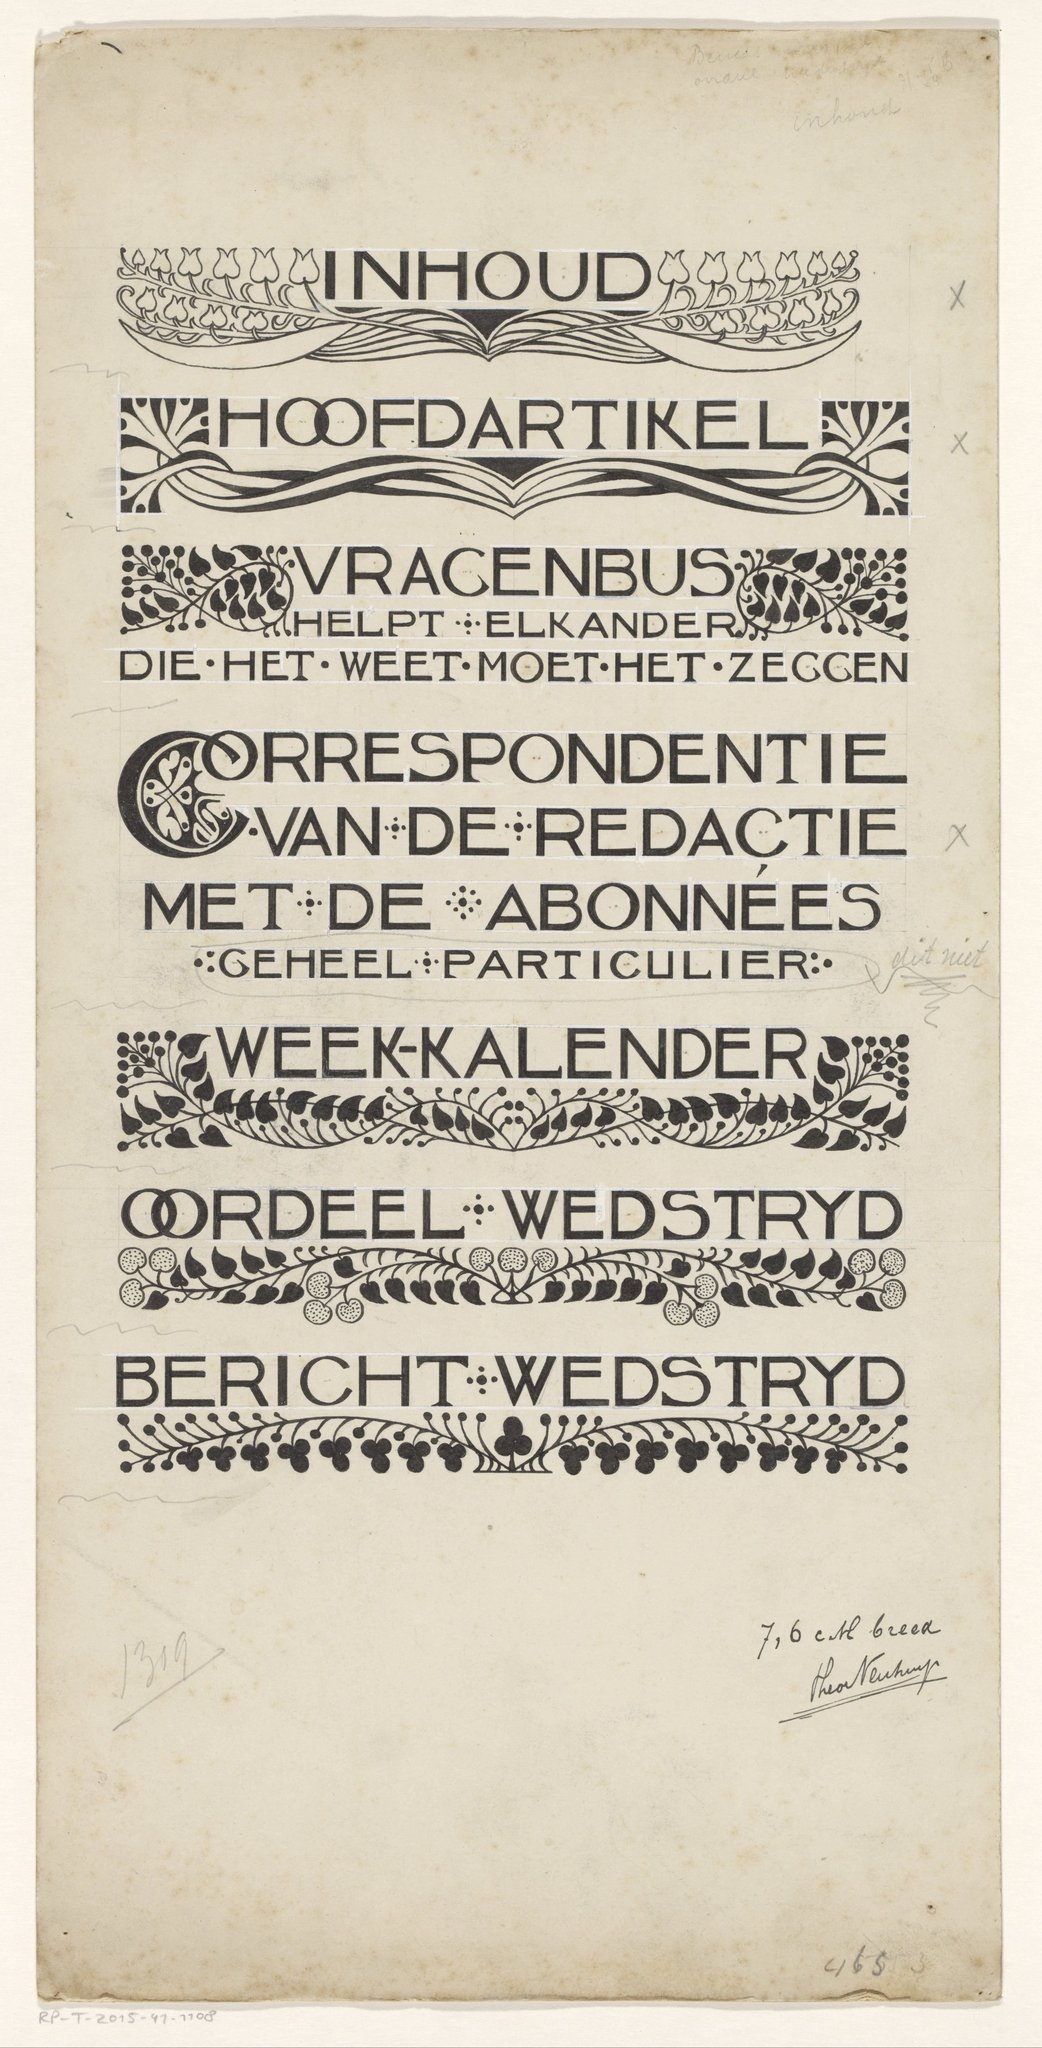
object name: drawing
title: Ontwerp voor: De Hollandsche Lelie, Weekblad voor jonge dames, c. 1892-1919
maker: theo neuhuys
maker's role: draughtsman, print maker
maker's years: 1878-1921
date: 1892-1919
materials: cardboard, paint, ink, pencil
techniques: brush, pen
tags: foliage, tendrils, branches ~ ornament, flowers ~ ornament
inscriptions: collector's mark: Lugt 2228, signature: ‘Theo Neuhuys’, annotation: ‘Be[...]/ inhoud/ dit niet’, :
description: Ontwerp voor een inhoudsopgave met blad- en bloemornamenten.